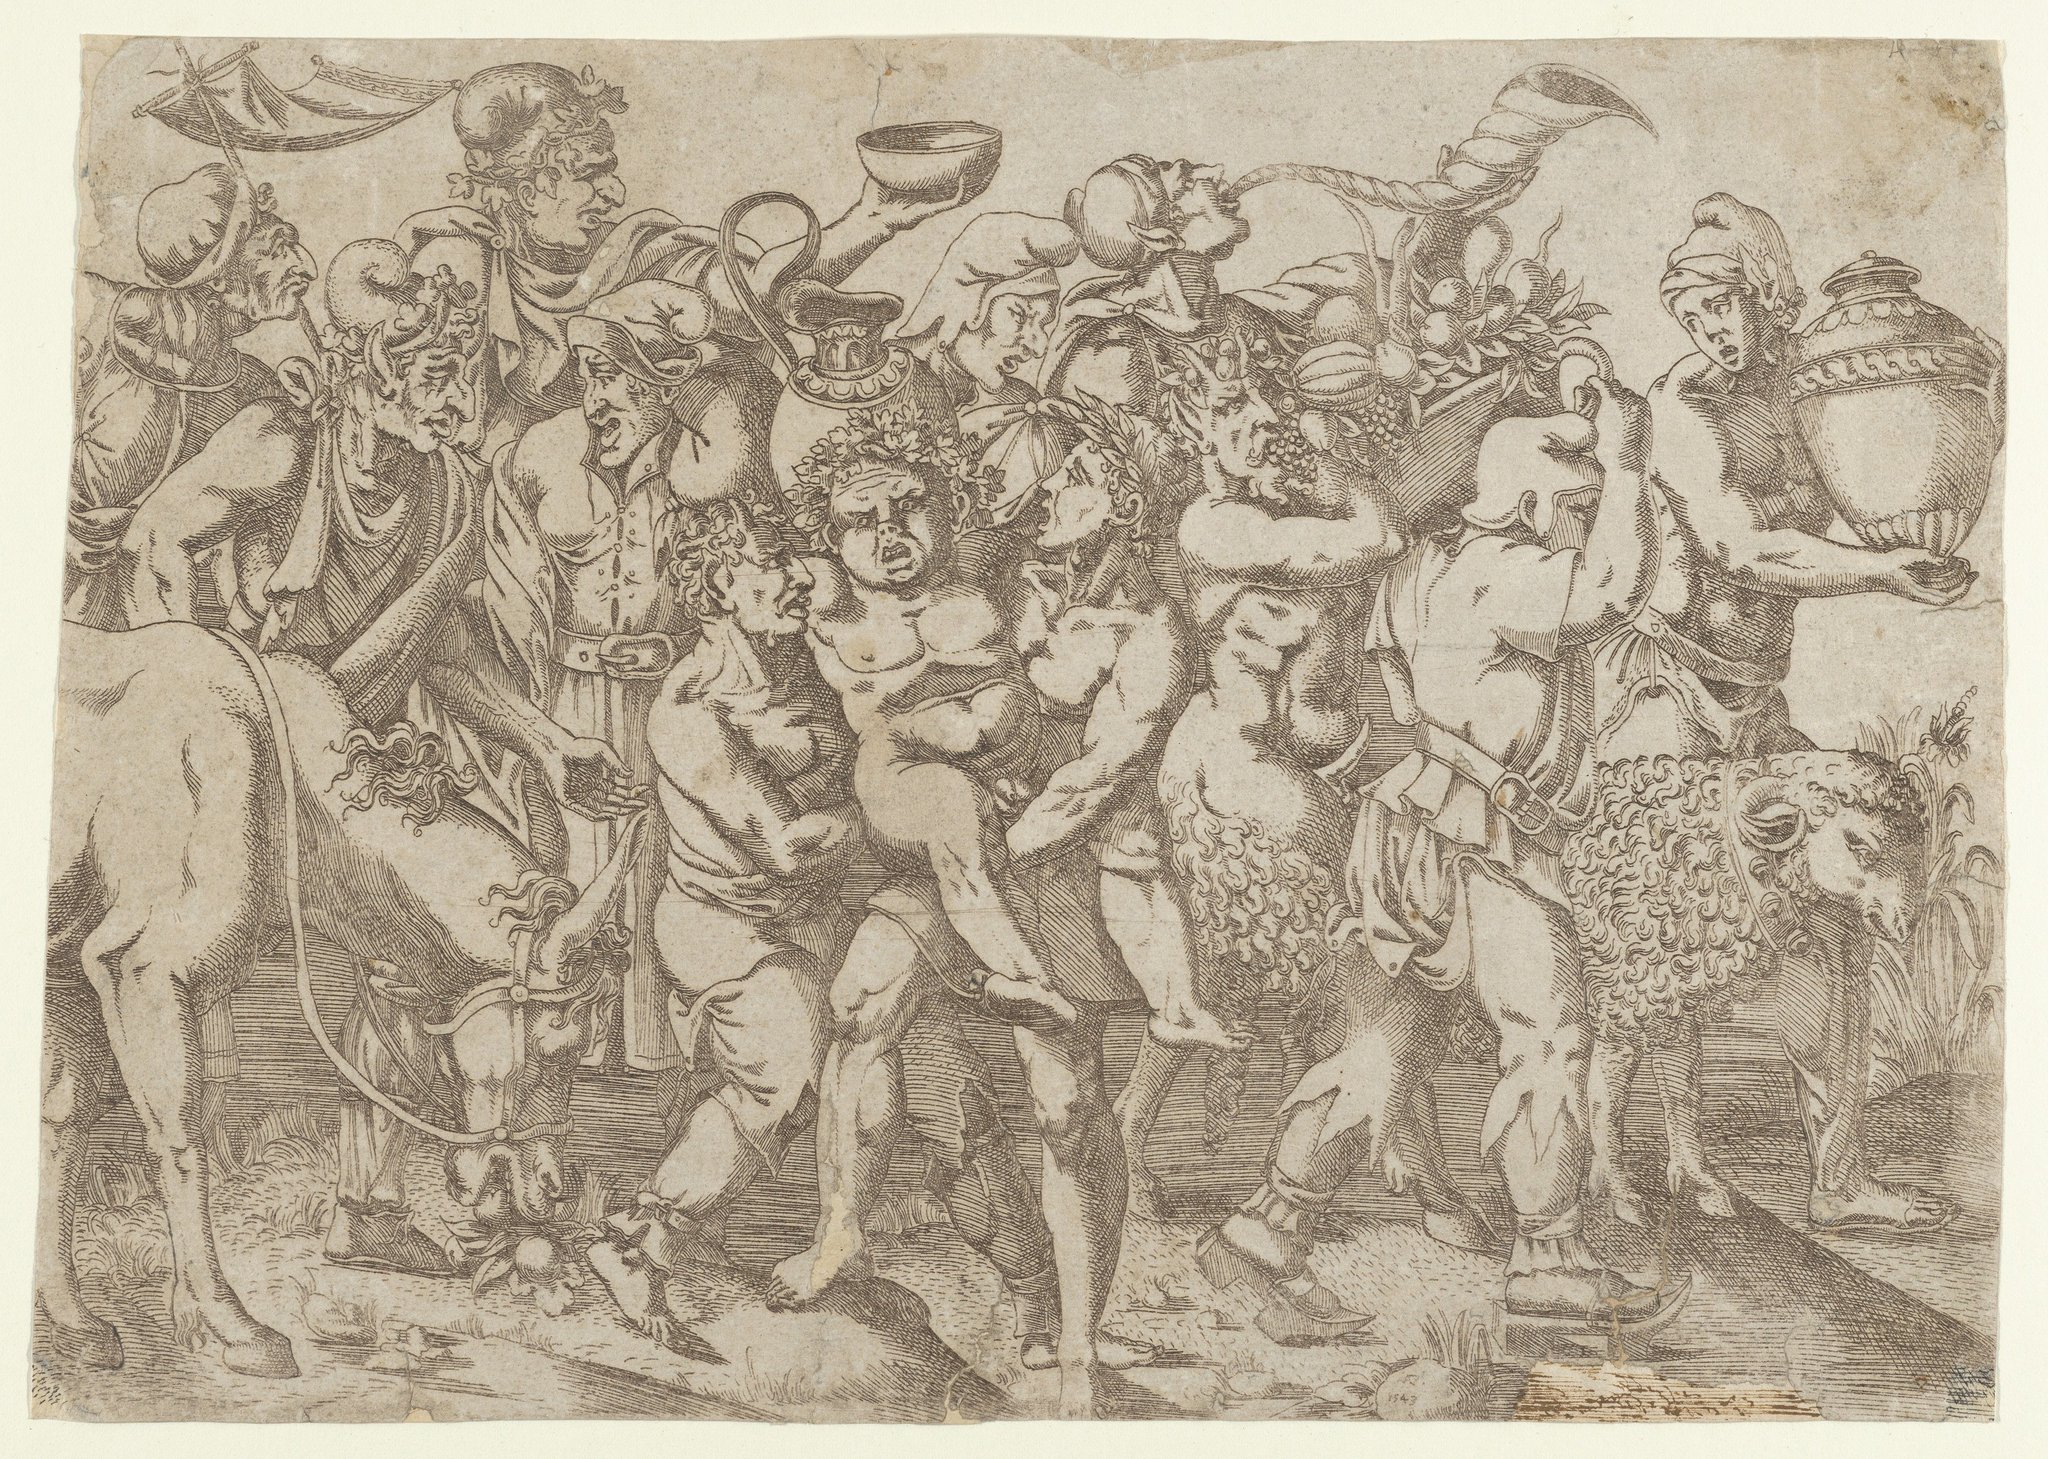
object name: print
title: Silenus Carried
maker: antonio fantuzzi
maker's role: artist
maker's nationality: italian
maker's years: 1537-1545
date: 1543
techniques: etching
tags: musical instruments,men,silenus,horses